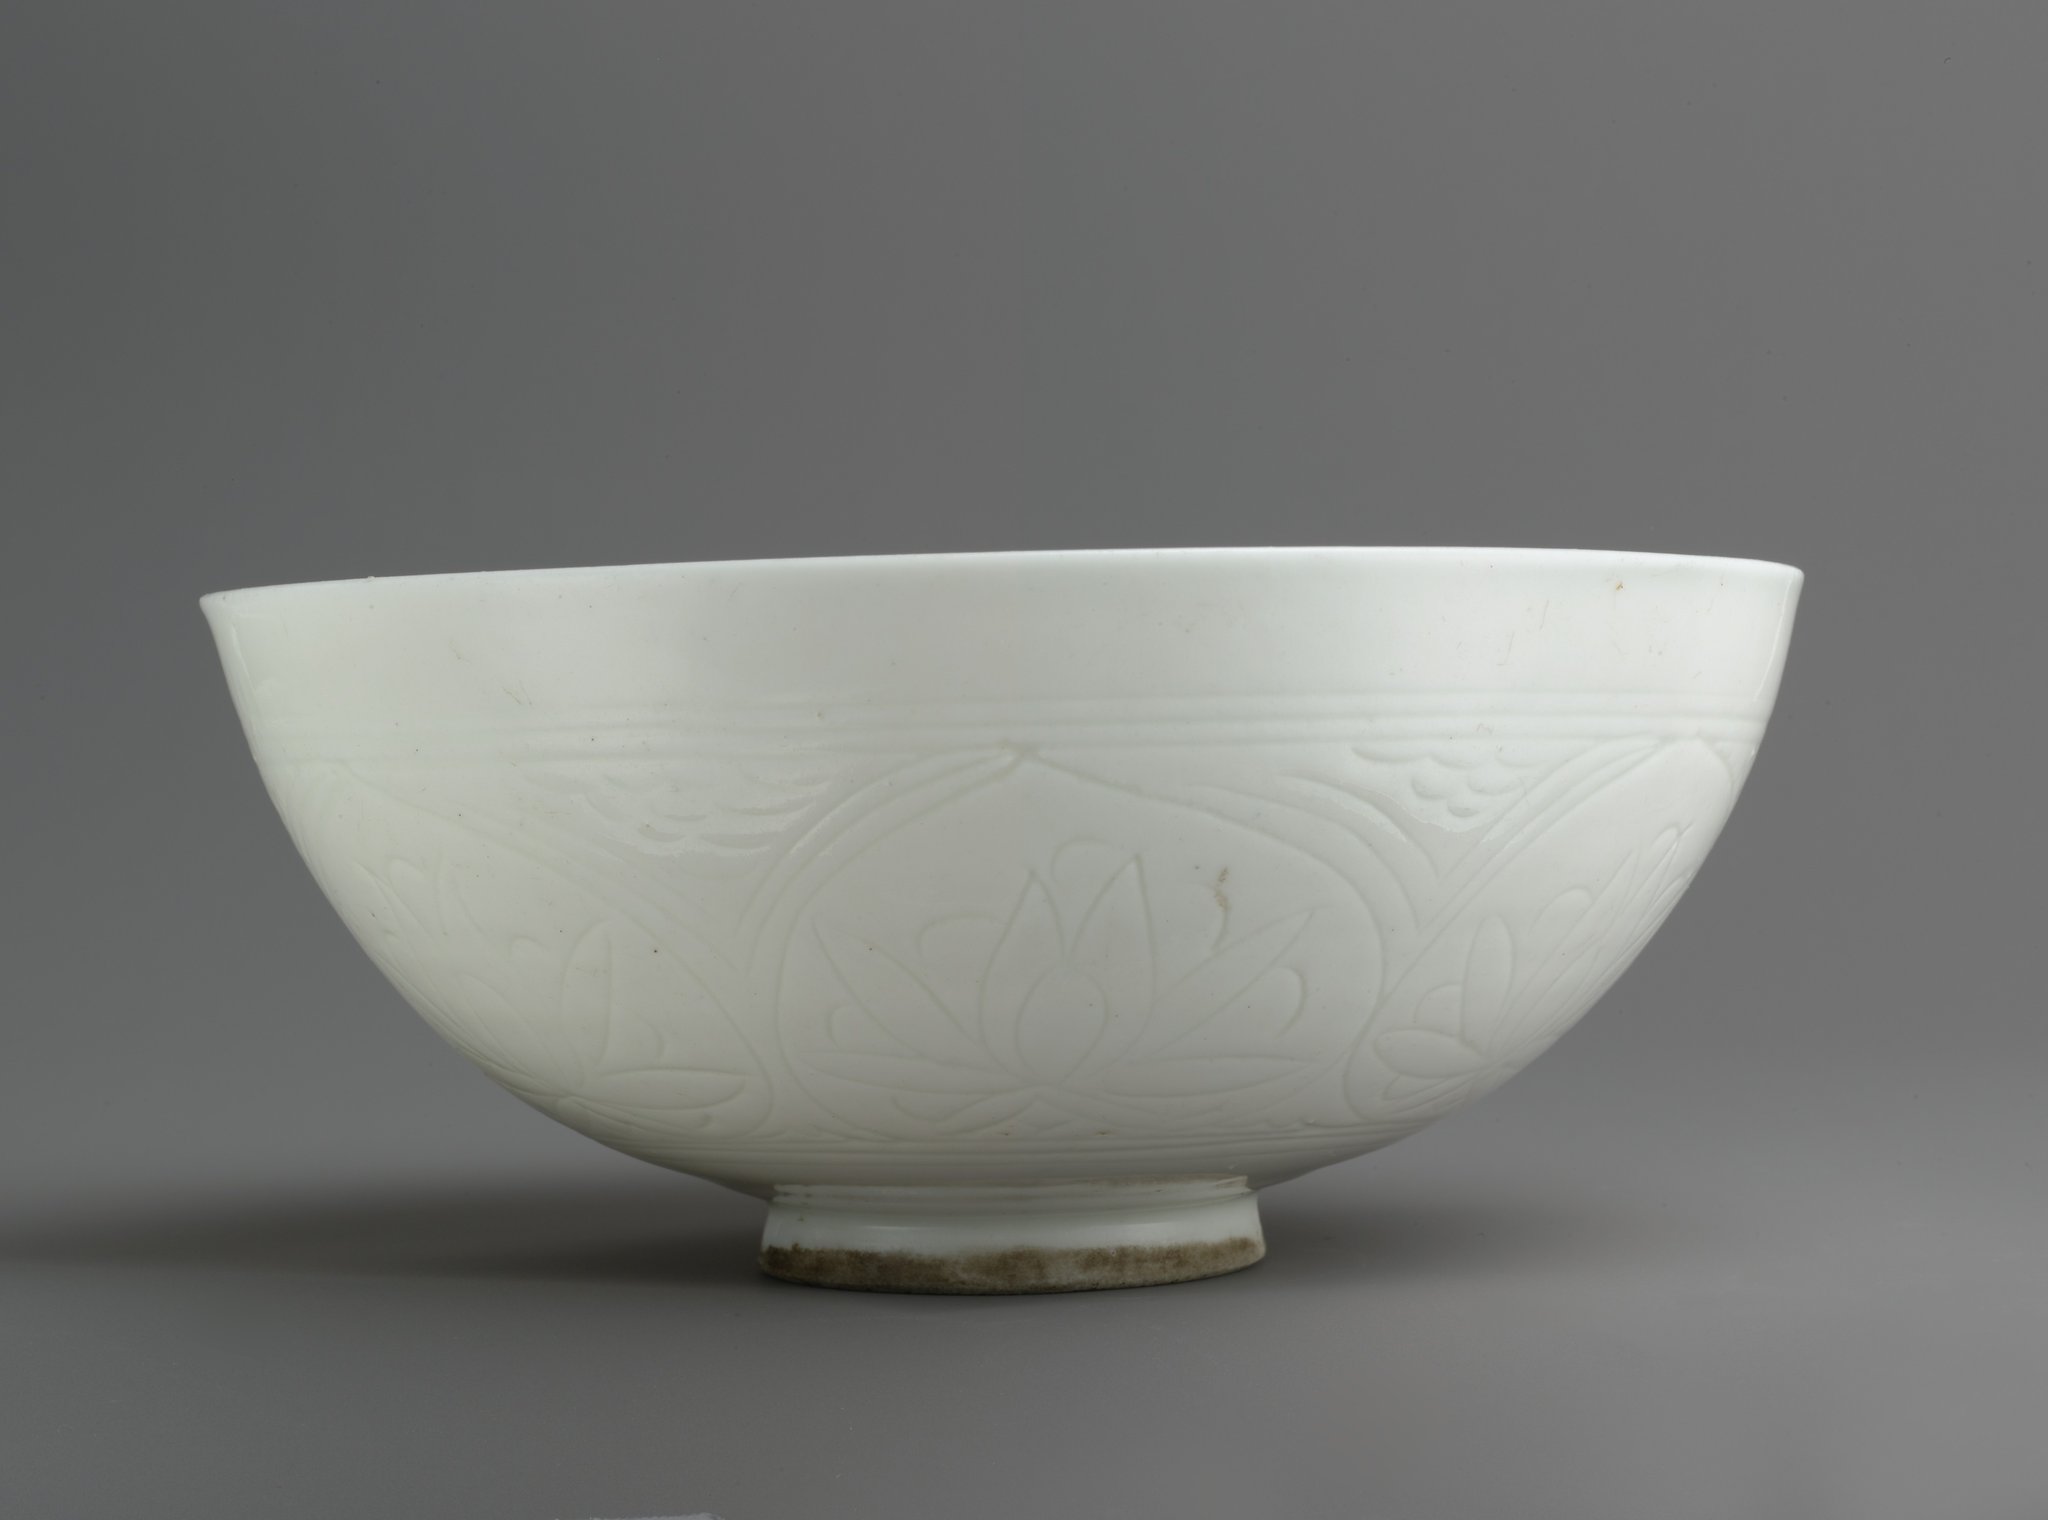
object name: bowl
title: Bowl with Incised Lotus Flowers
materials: glaze, stonepaste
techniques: incising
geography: iran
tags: lotuses